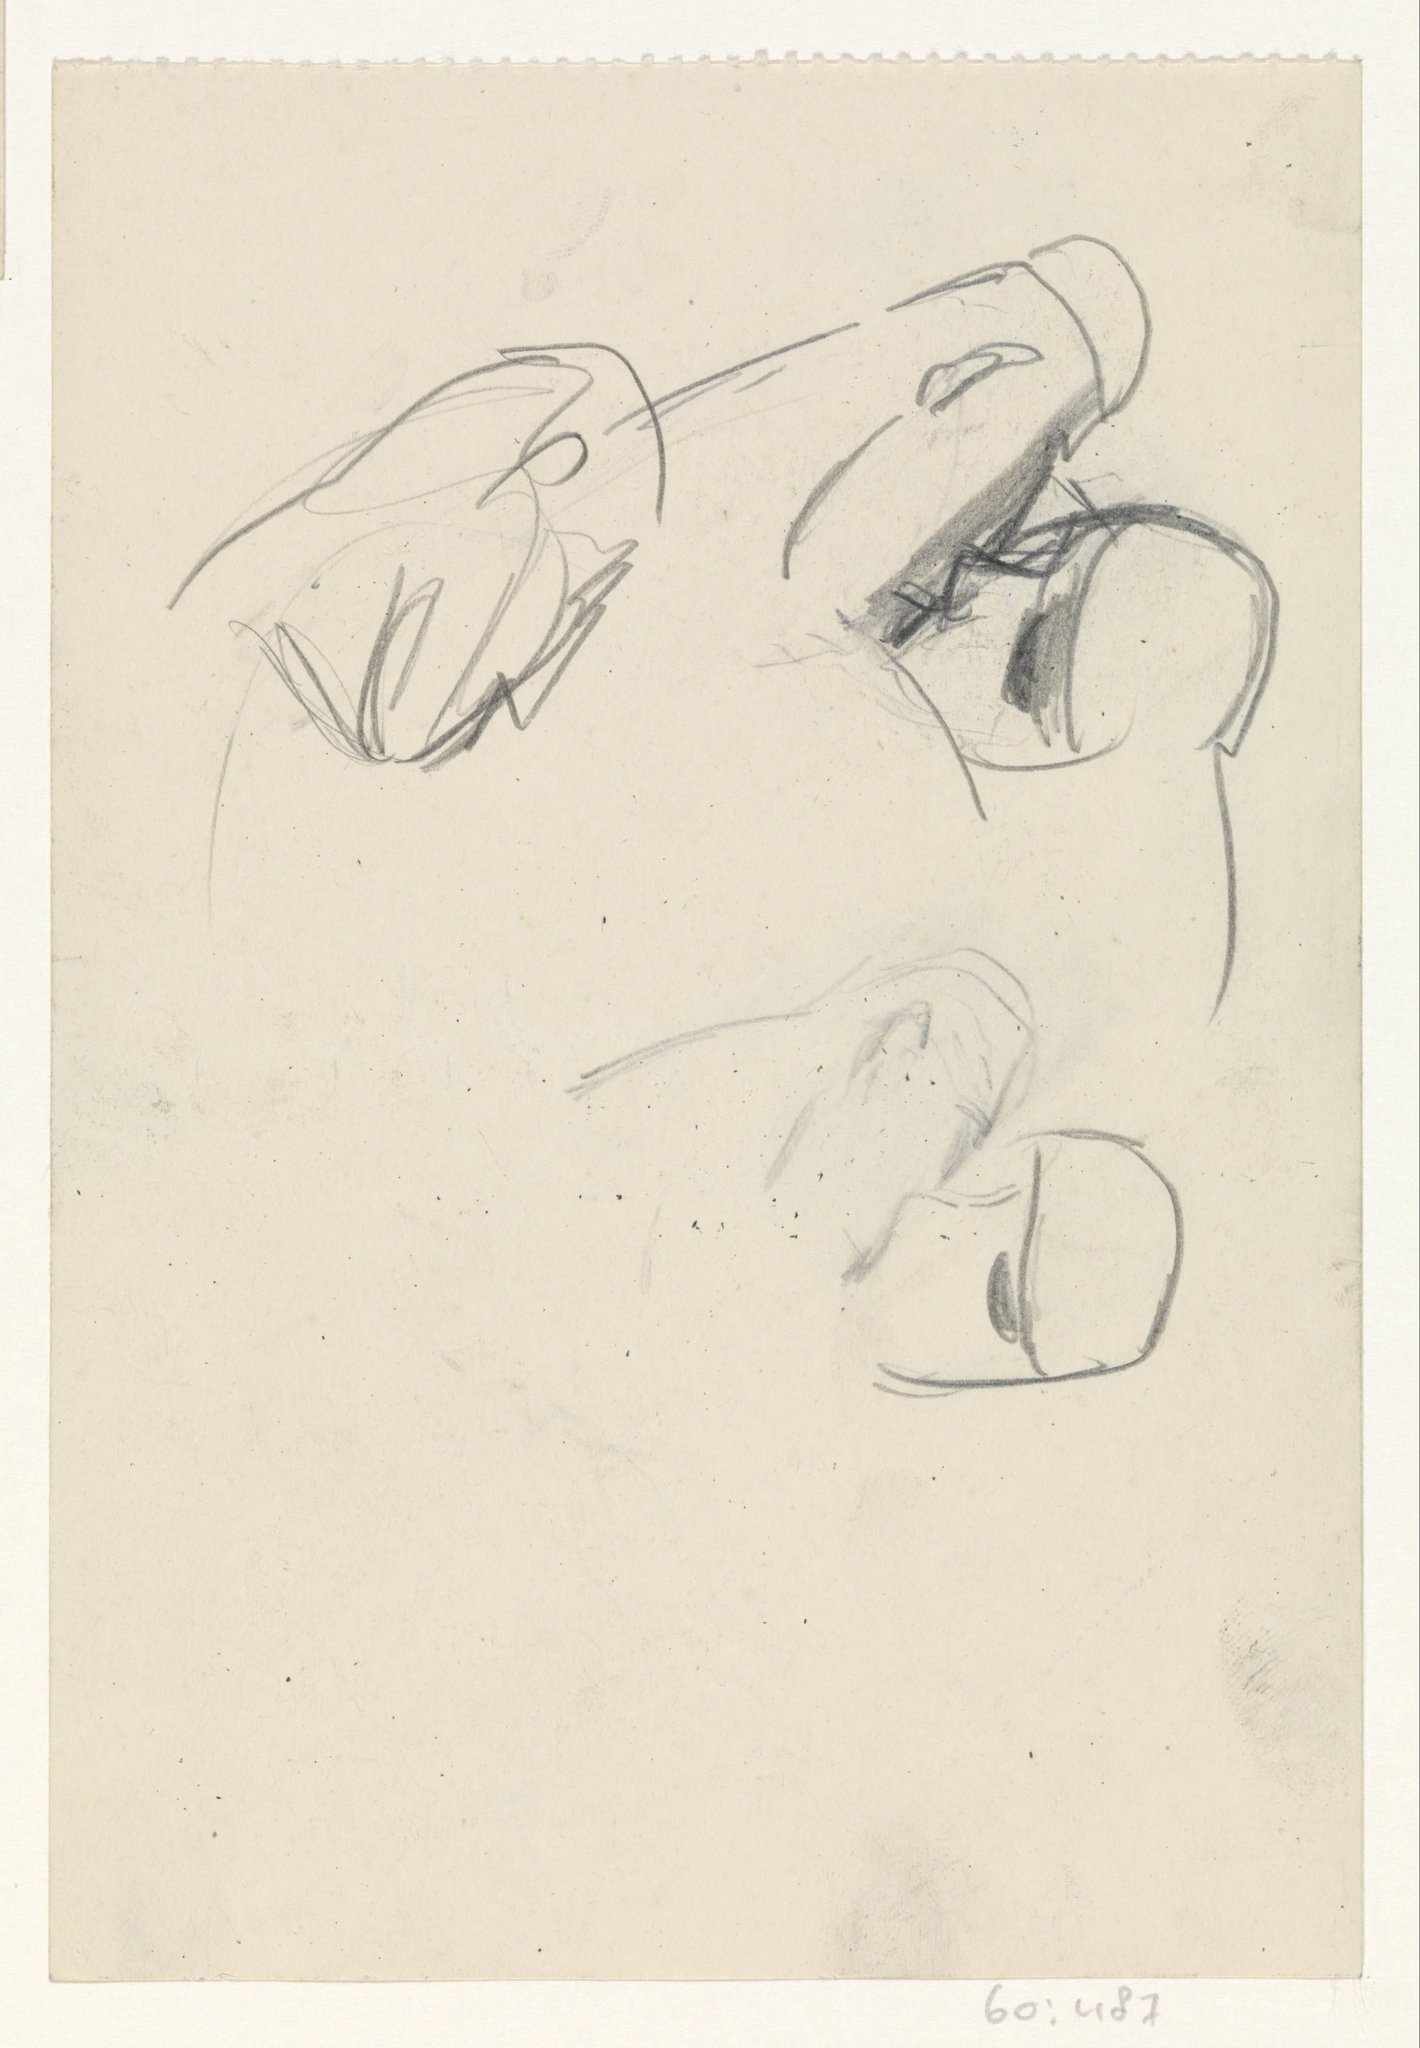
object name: drawing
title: Twee kussende stellen en een mannenhoofd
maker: leo gestel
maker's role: draughtsman, print maker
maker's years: 1881-1941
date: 1891-1941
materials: paper, pencil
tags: (lovers) kissing each other, embracing each other, kissing